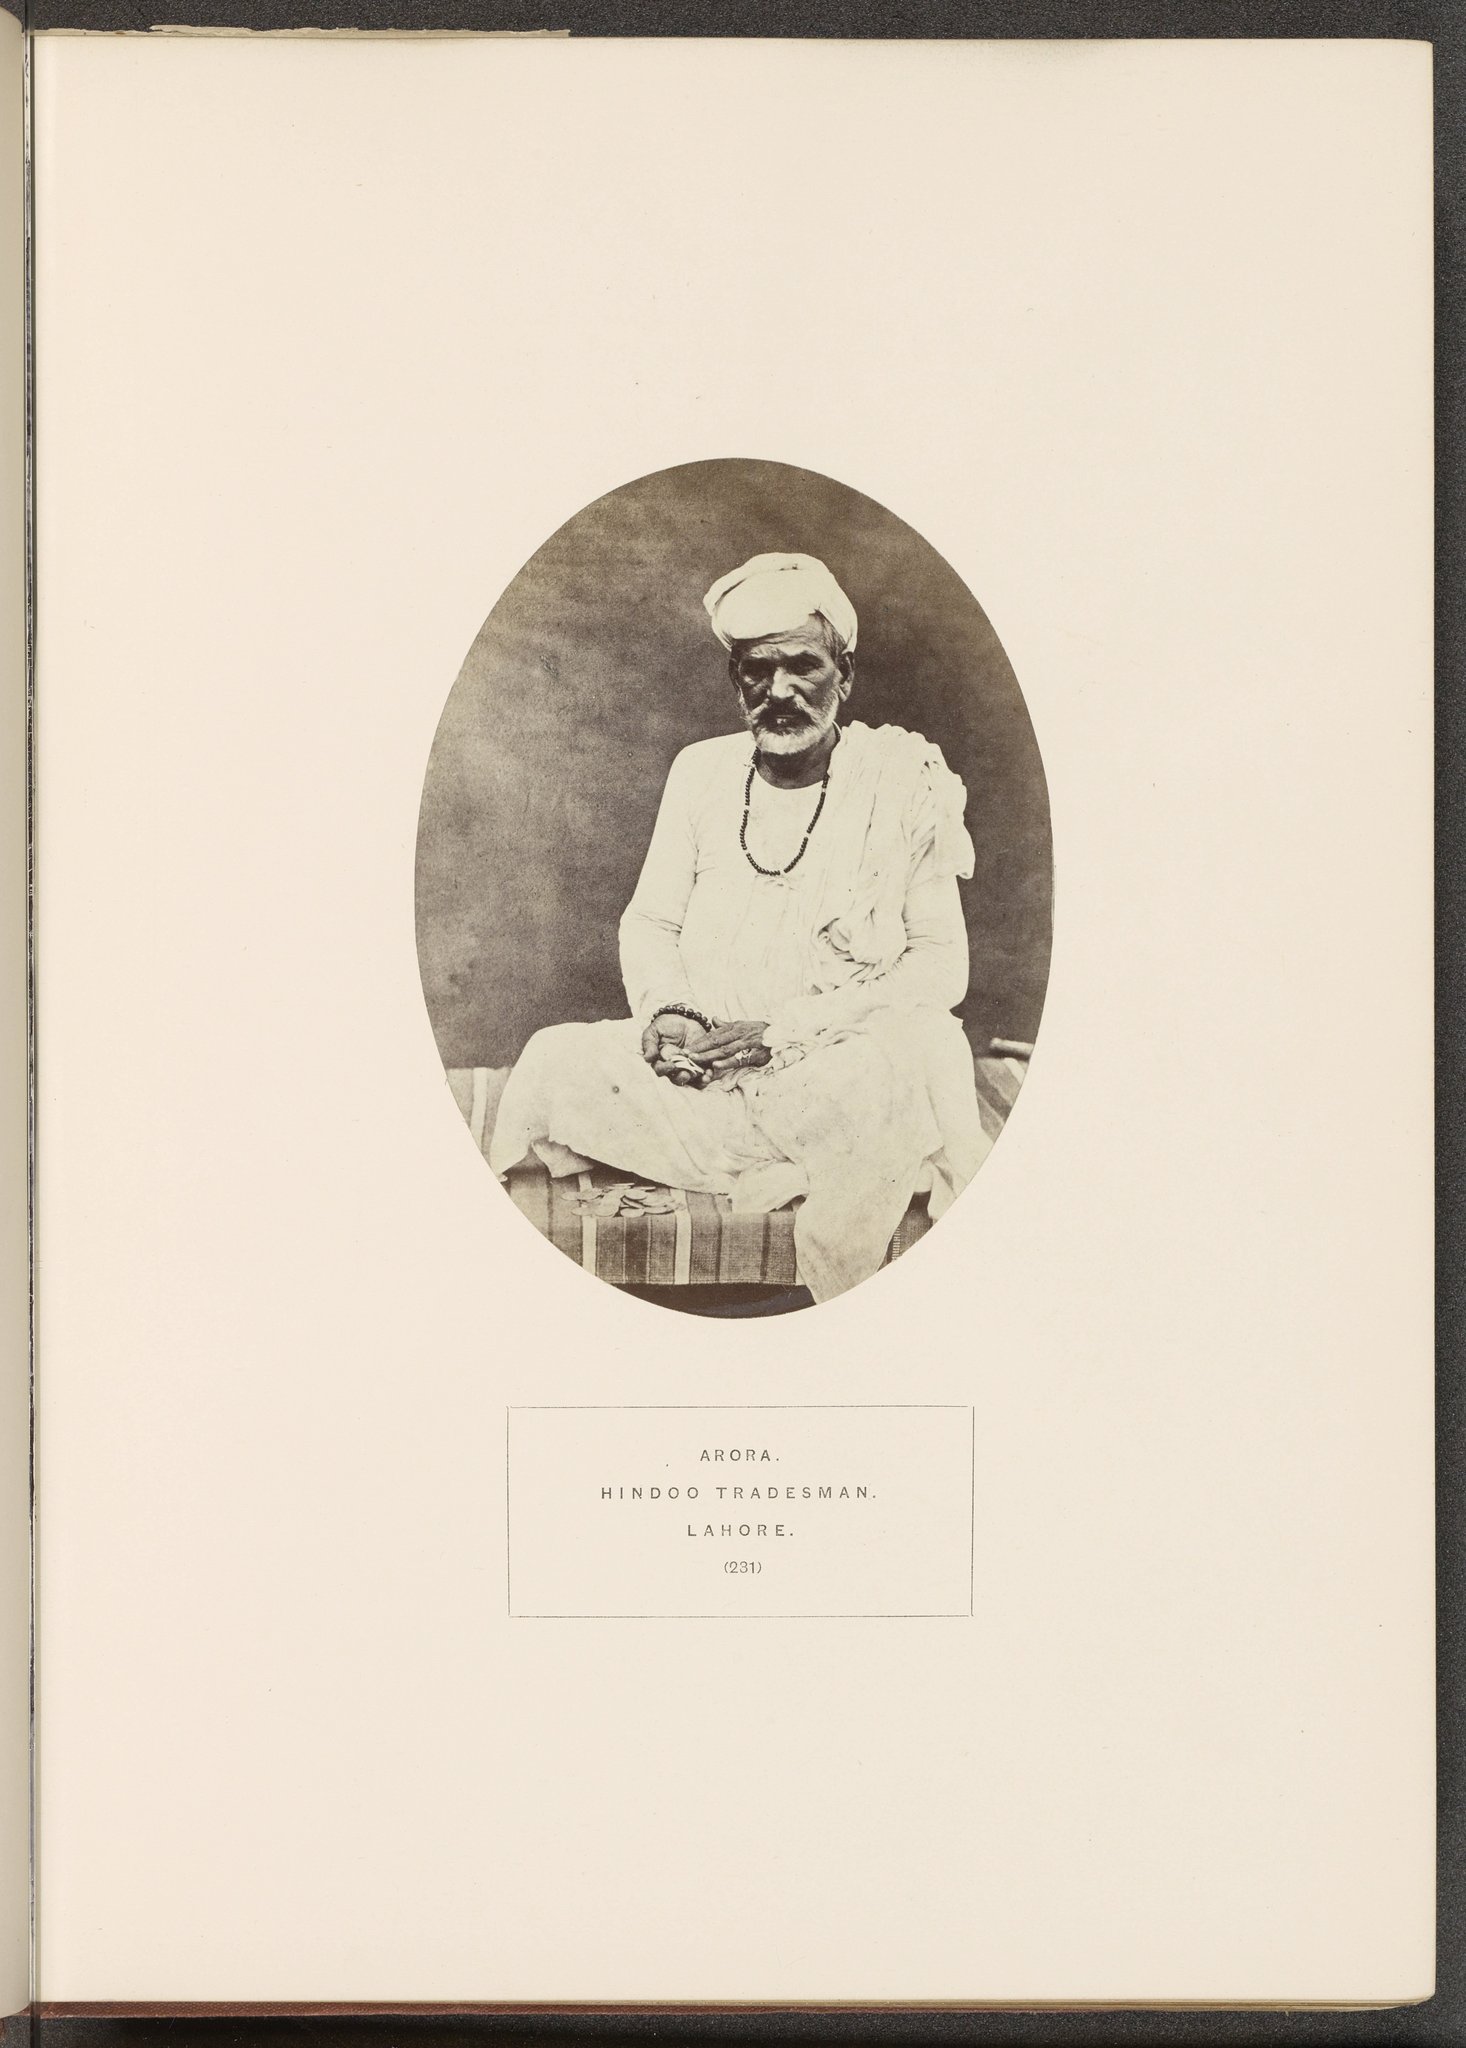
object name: page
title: Portrait of an unknown tradesman from the Arora community of Lahore, Punjab, Pakistan, with coins in hand and in front of him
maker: Anonymous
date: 1862-1872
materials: photographic support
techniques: albumen print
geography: lahore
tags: coin, human races; peoples; nationalities, persons engaged in trade and commerce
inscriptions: inscription: ‘ARORA./ HINDOO TRADESMAN./ LAHORE.’, number: ‘(231)’